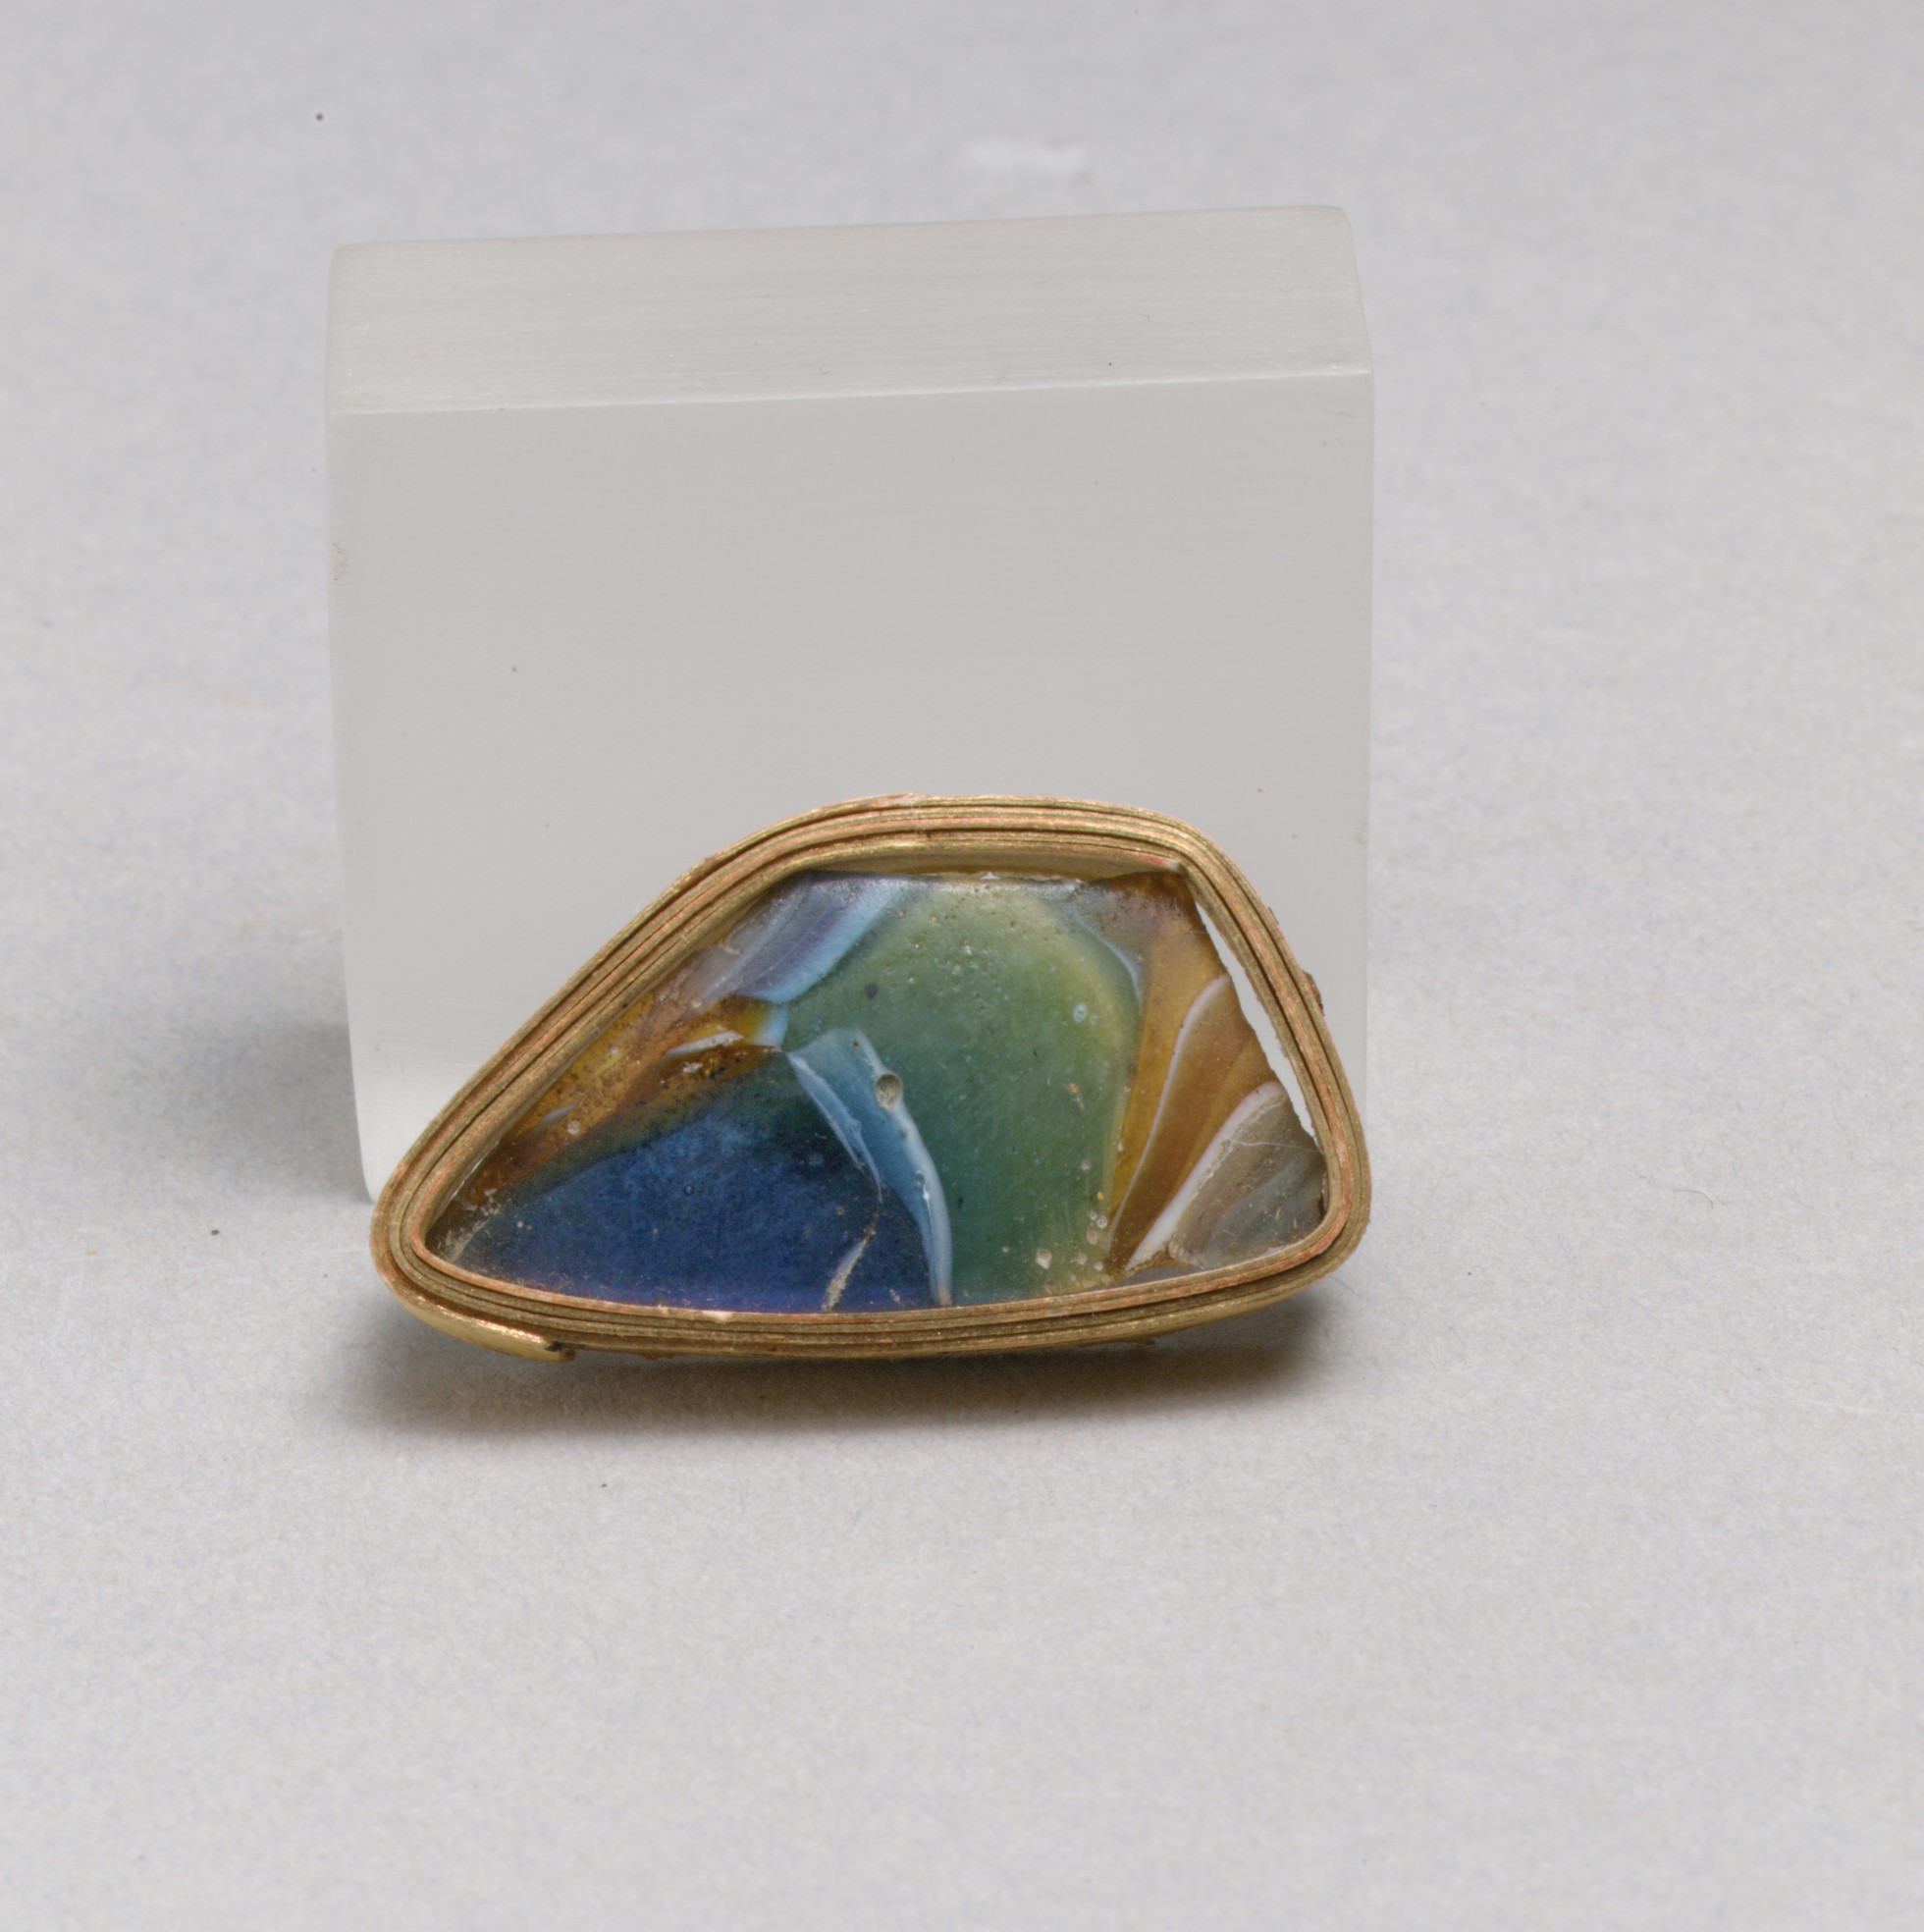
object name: fragment, mosaic bowl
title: Glass mosaic bowl fragment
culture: roman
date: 34 BCE-33 CE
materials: glass